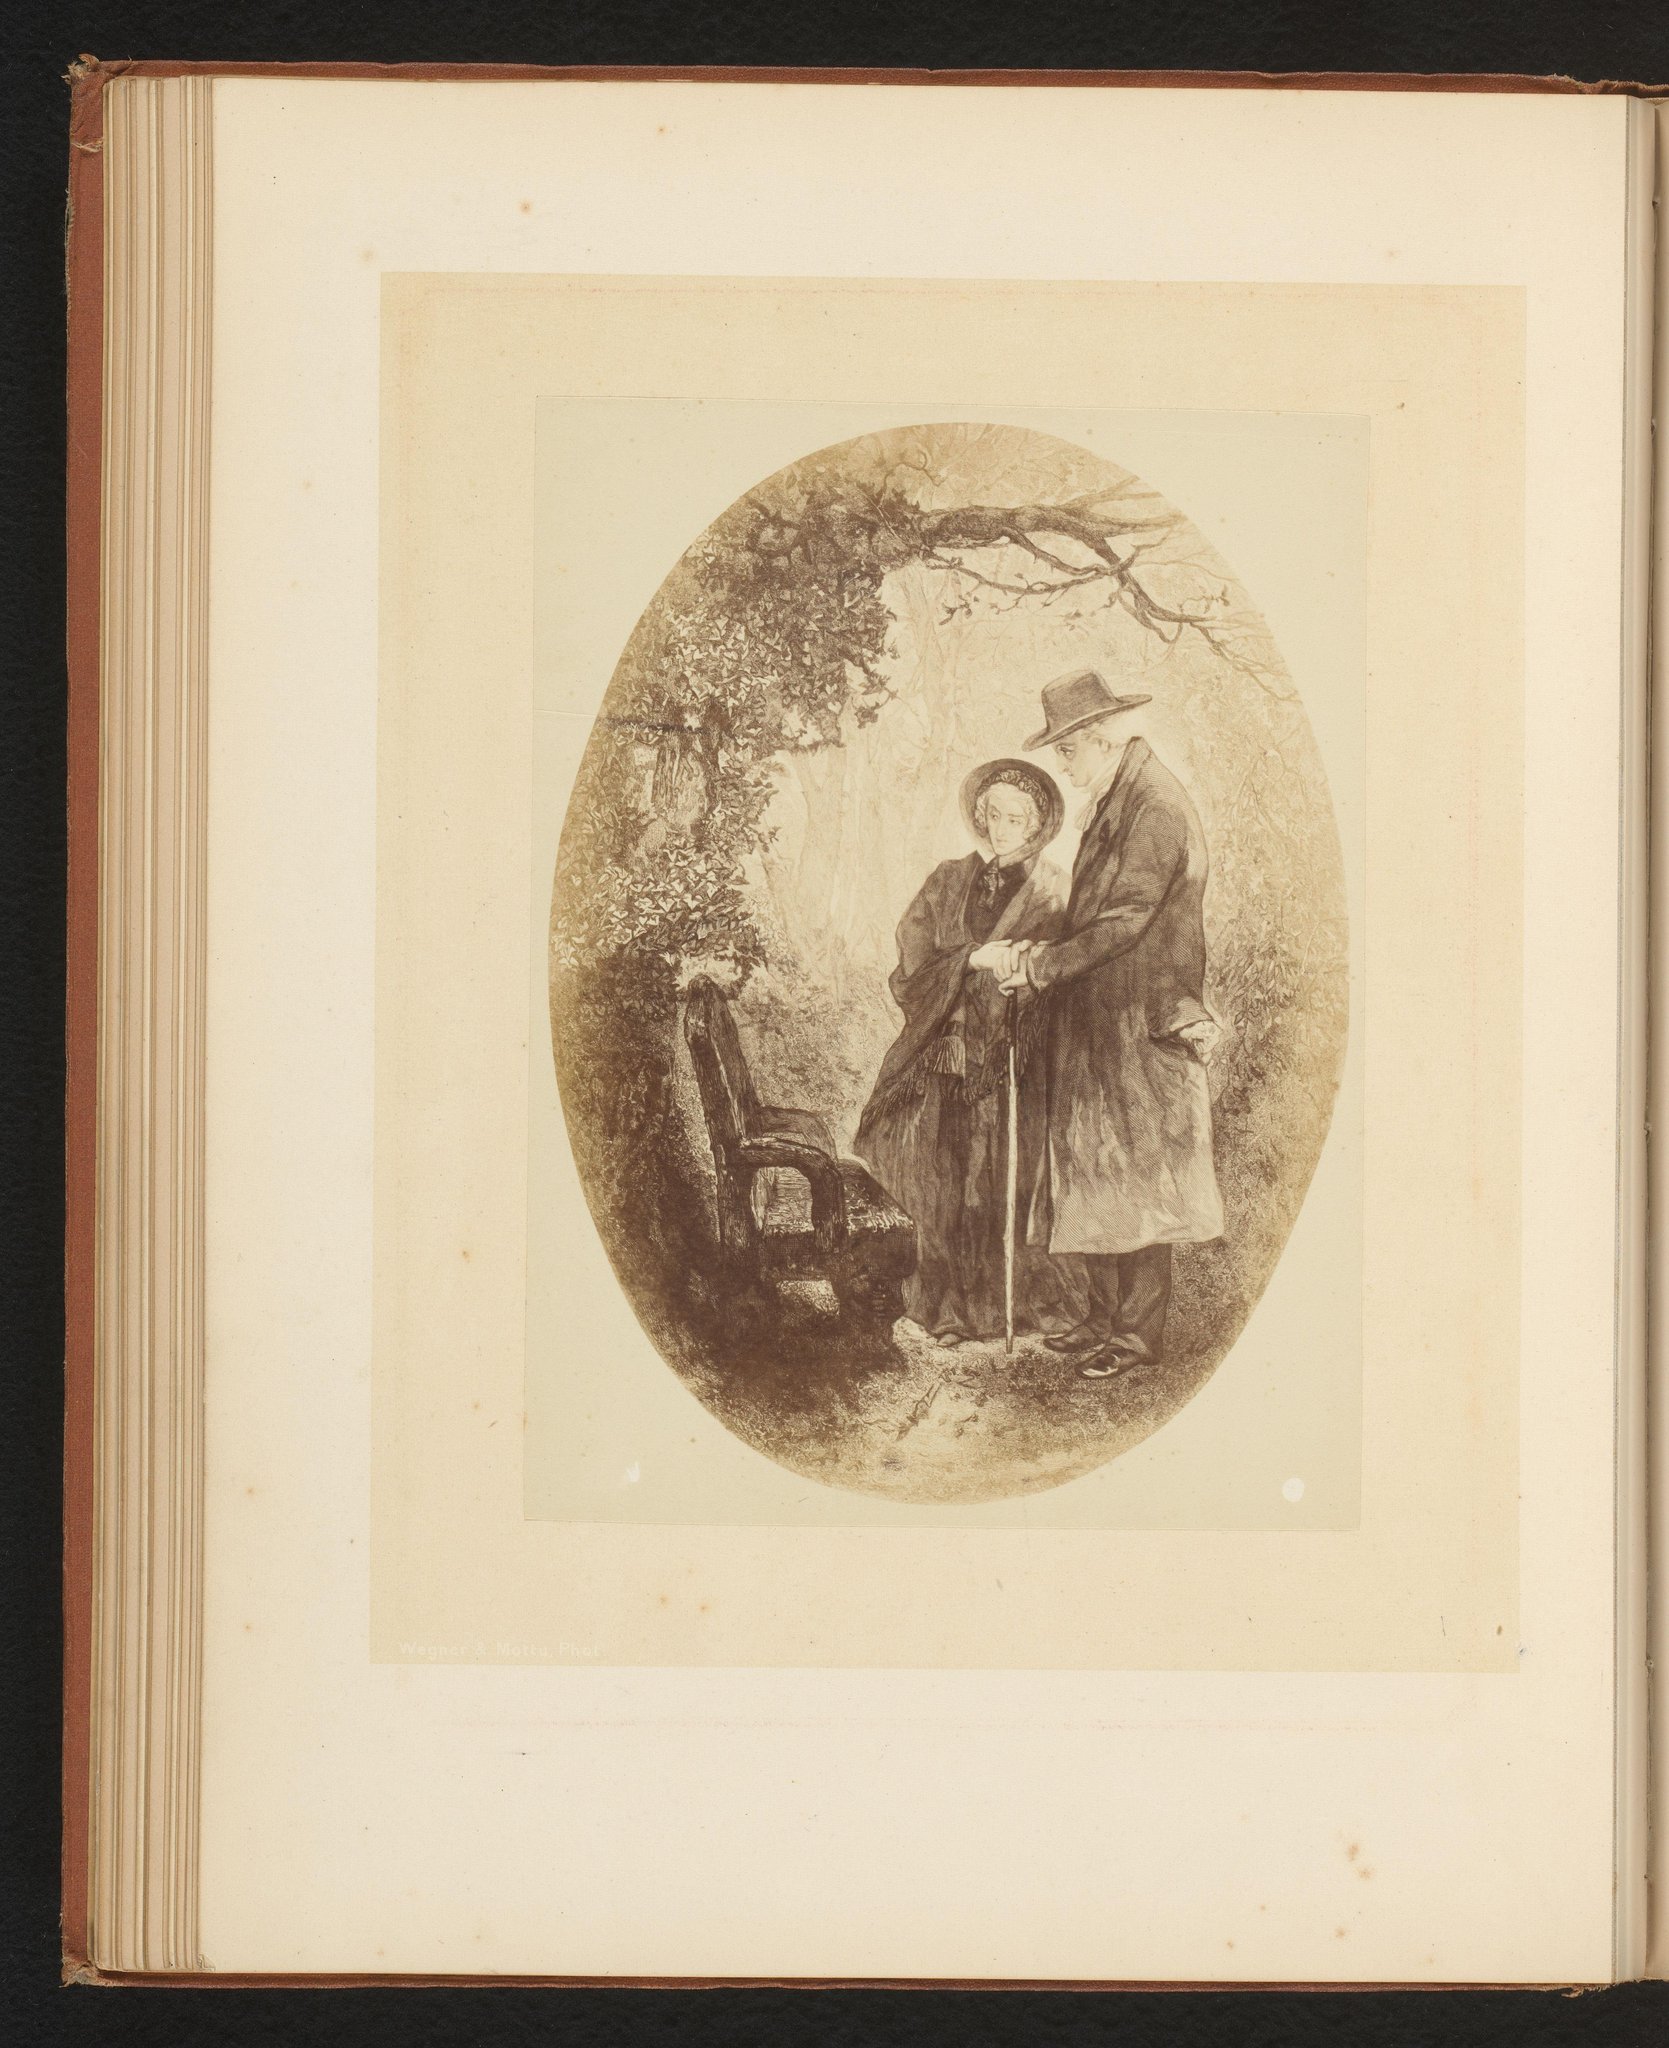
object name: page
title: Fotoreproductie van een gravure naar een schilderij door Charles Rochussen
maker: charles rochussen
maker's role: draughtsman, painter, print maker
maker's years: 1814-1894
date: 1866-1871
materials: paper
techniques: albumen print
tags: print, e.g.: engraving, etching, lithograph